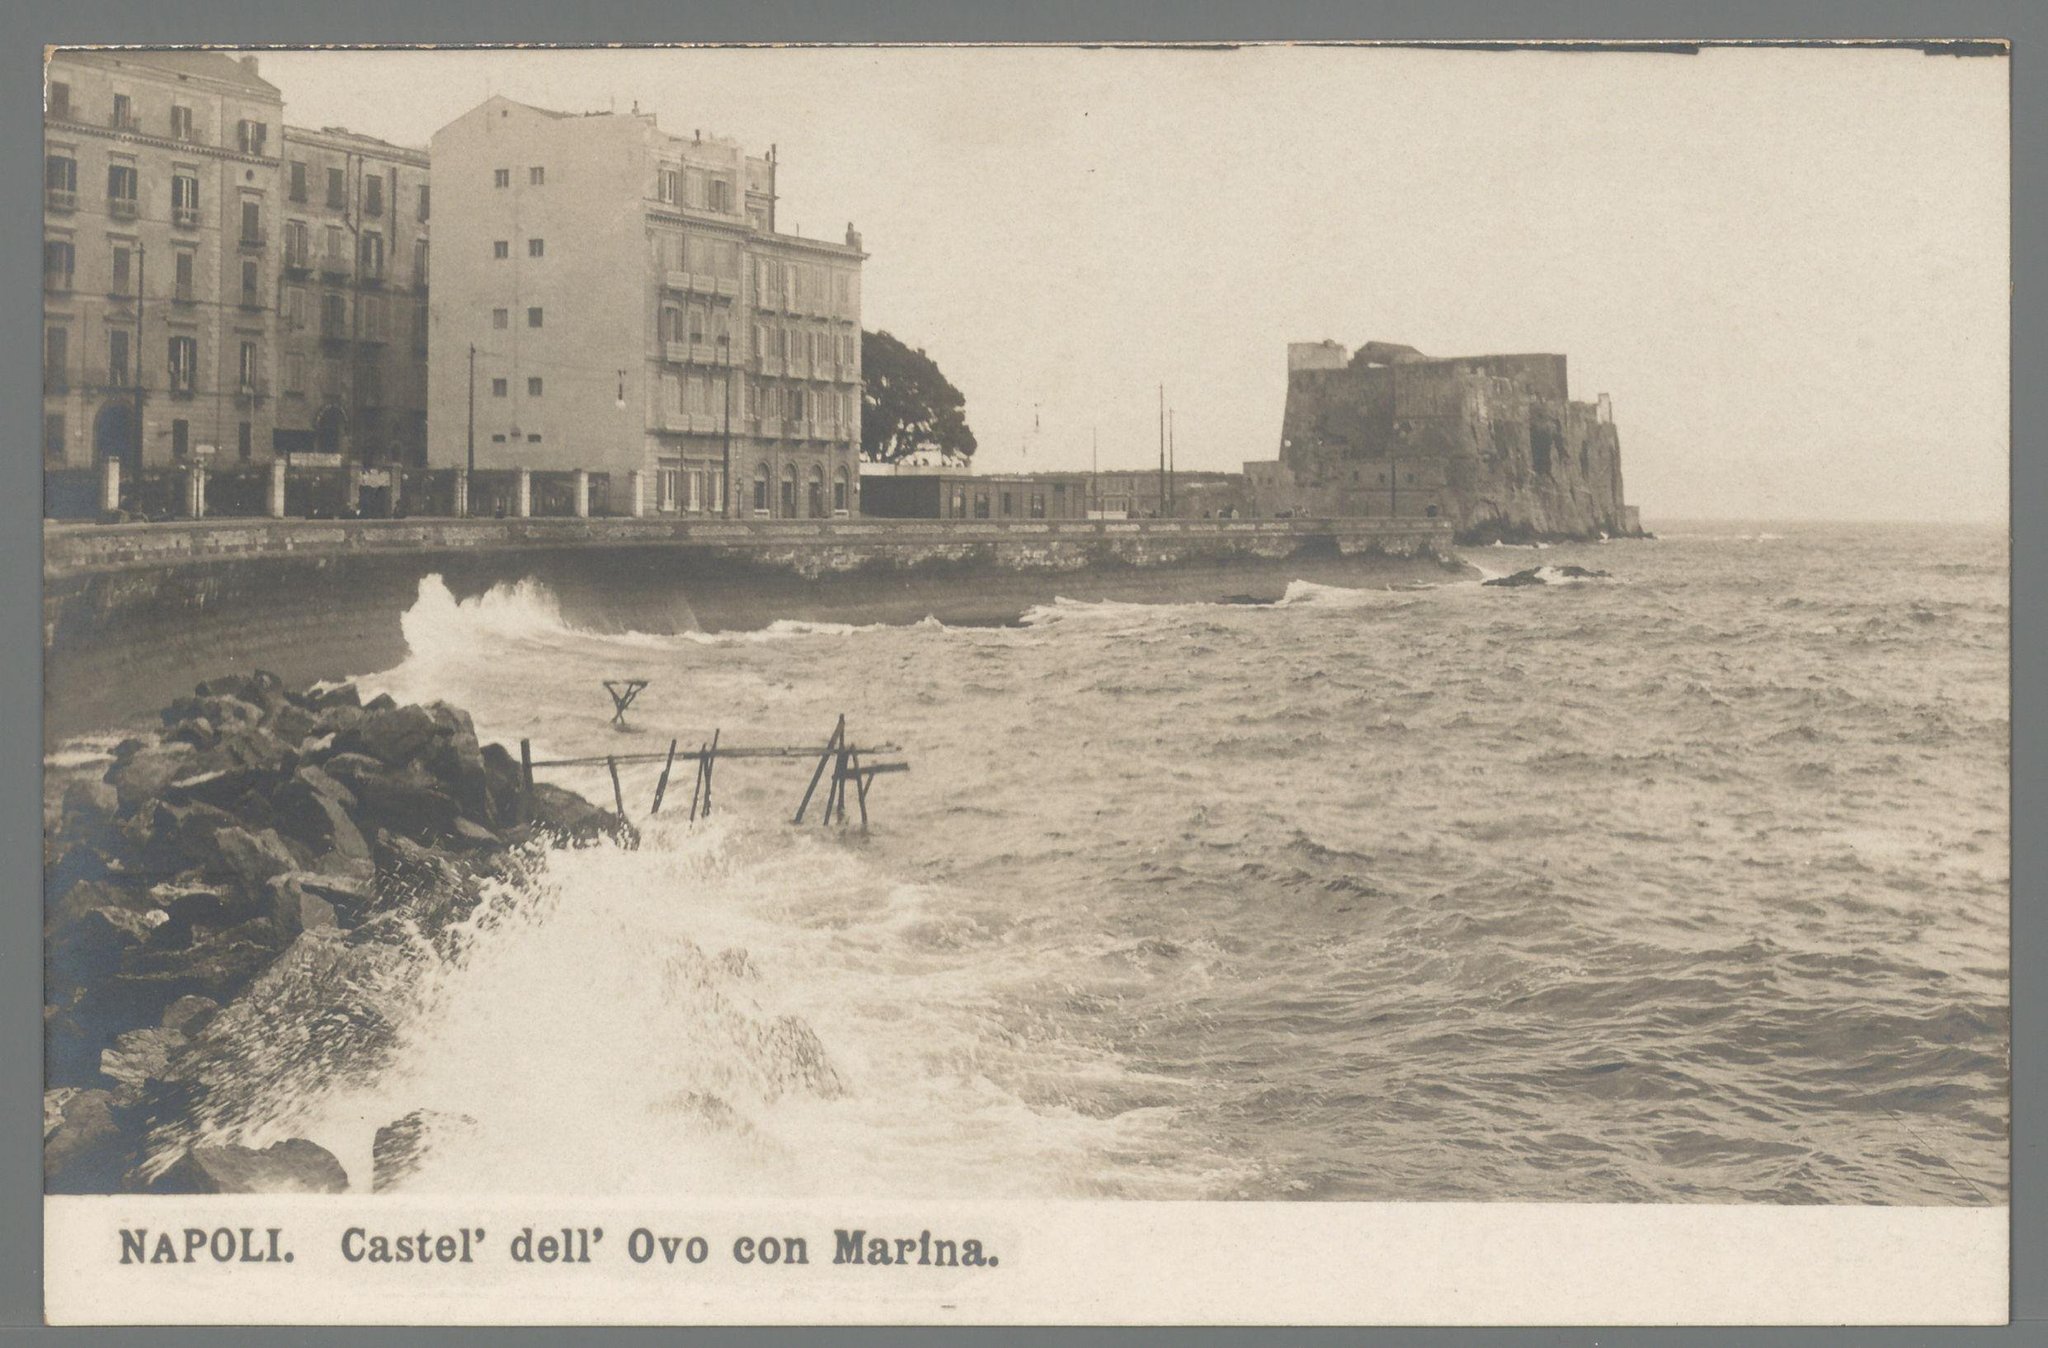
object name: ansichtkaart, prentbriefkaart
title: Napoli. Castel'dell'Ovo con Marina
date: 1900-1906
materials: photographic support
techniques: photography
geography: naples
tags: gulf, bay, castle